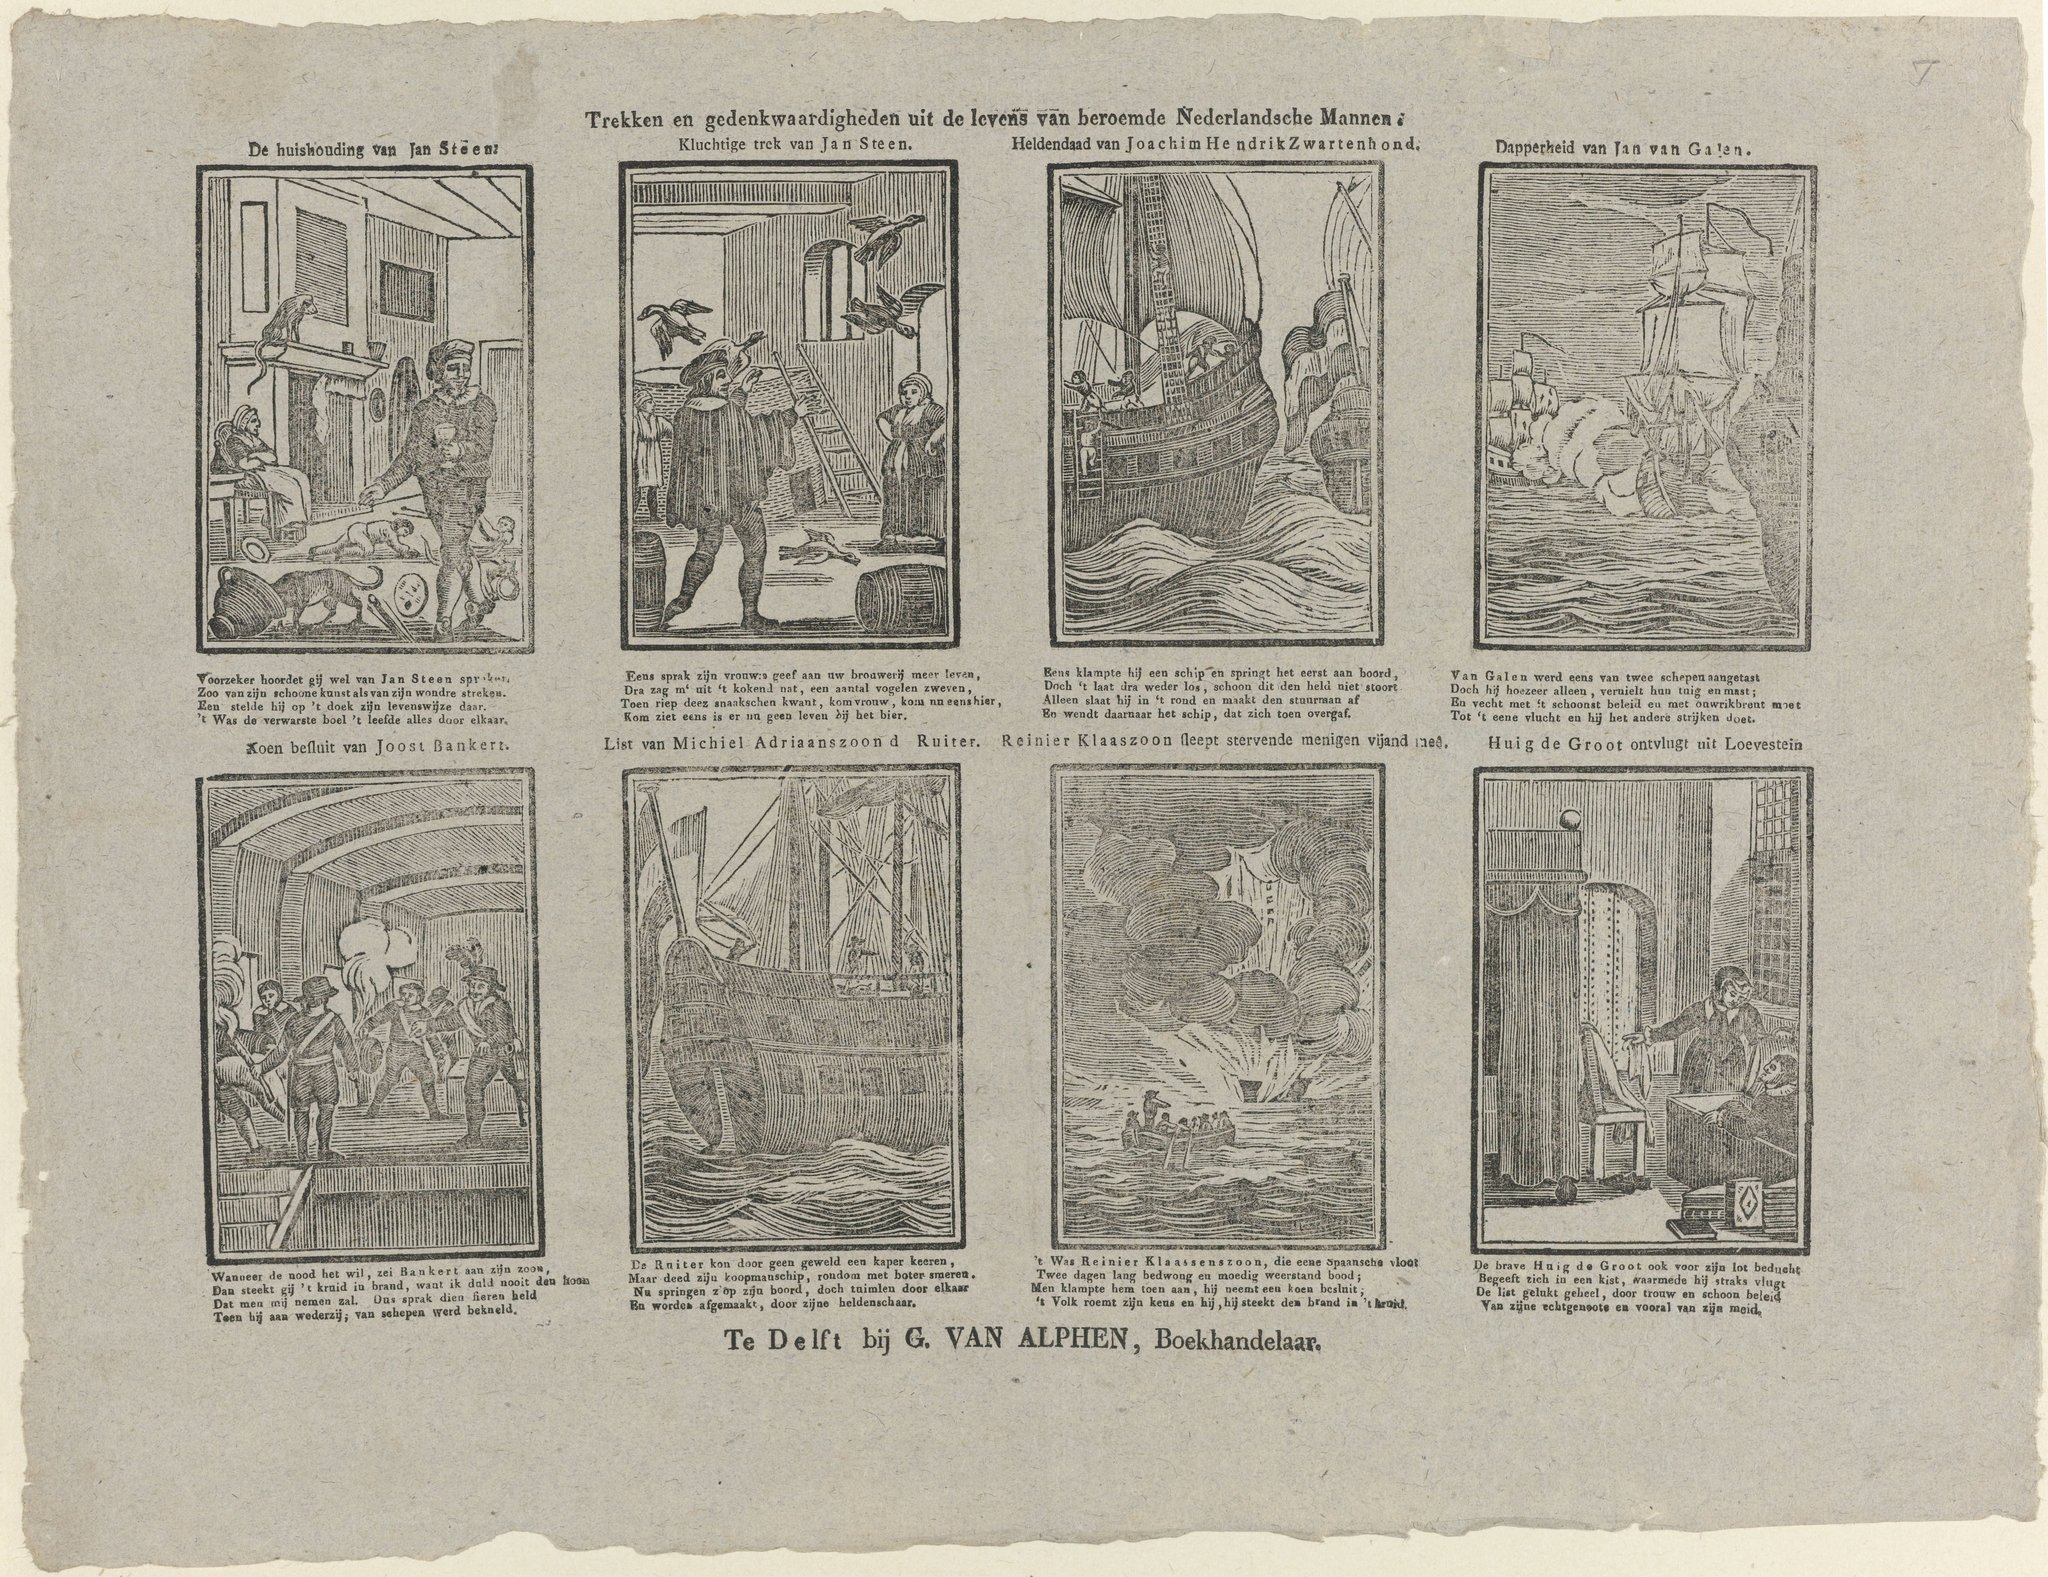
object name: print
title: Trekken en gedenkwaardigheden uit de levens van beroemde Nederlandsche mannen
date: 1819-1840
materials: paper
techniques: letterpress printing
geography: delft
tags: delft, hugo de groot, jan havicksz. steen, flushing, michiel adriaenszoon de ruyter, amsterdam, a perfect shambles (dutch: 'huishouden van jan steen'), classical mythology and ancient history, loevestein castle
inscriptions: collector's mark: Lugt 2760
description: Blad met 8 voorstellingen uit het leven van beroemde Nederlandse mannen, onder wie Jan Steen, Jan van Galen, Michiel Adriaenszoon de Ruyter, Joachim Hendrik Swartenhondt en Hugo de Groot. Onder elke afbeelding een vierregelig vers en boven elke afbeelding een titel.